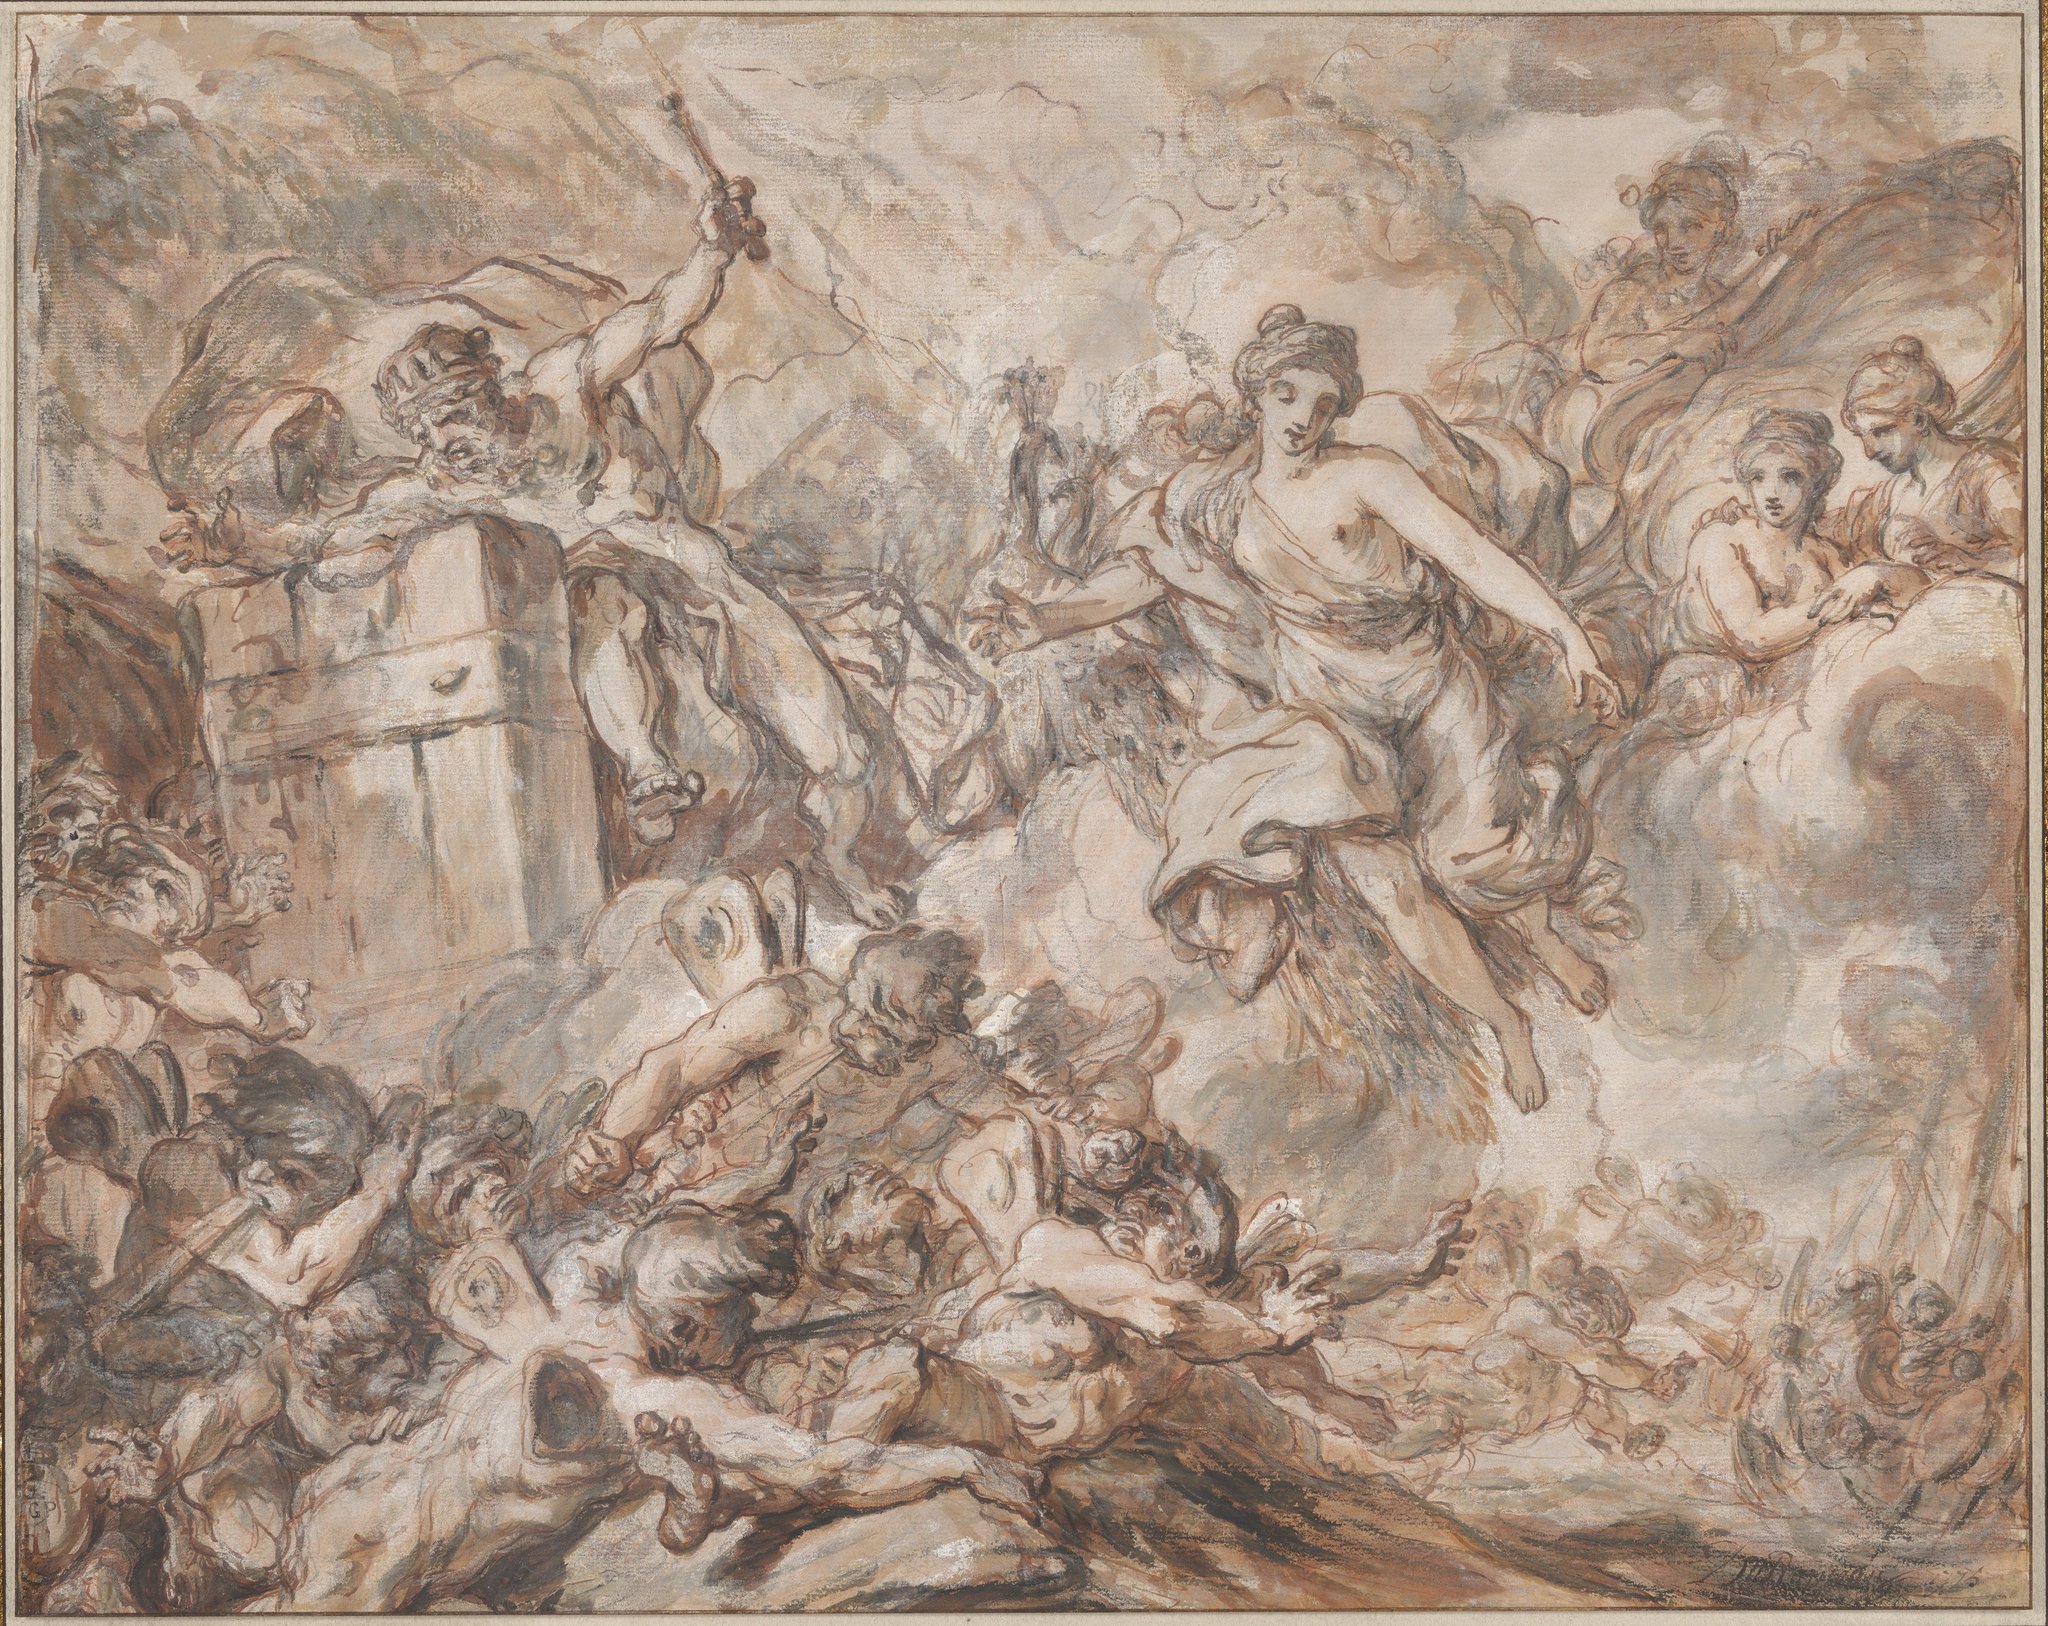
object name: drawing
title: Juno Ordering Aeolus to Unleash the Winds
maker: louis jean jacques durameau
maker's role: artist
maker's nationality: french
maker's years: 1733-1796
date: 1775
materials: chalk, gouache, ink, paper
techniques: brush, heightening, pen, drawing, wash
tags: men,women,juno